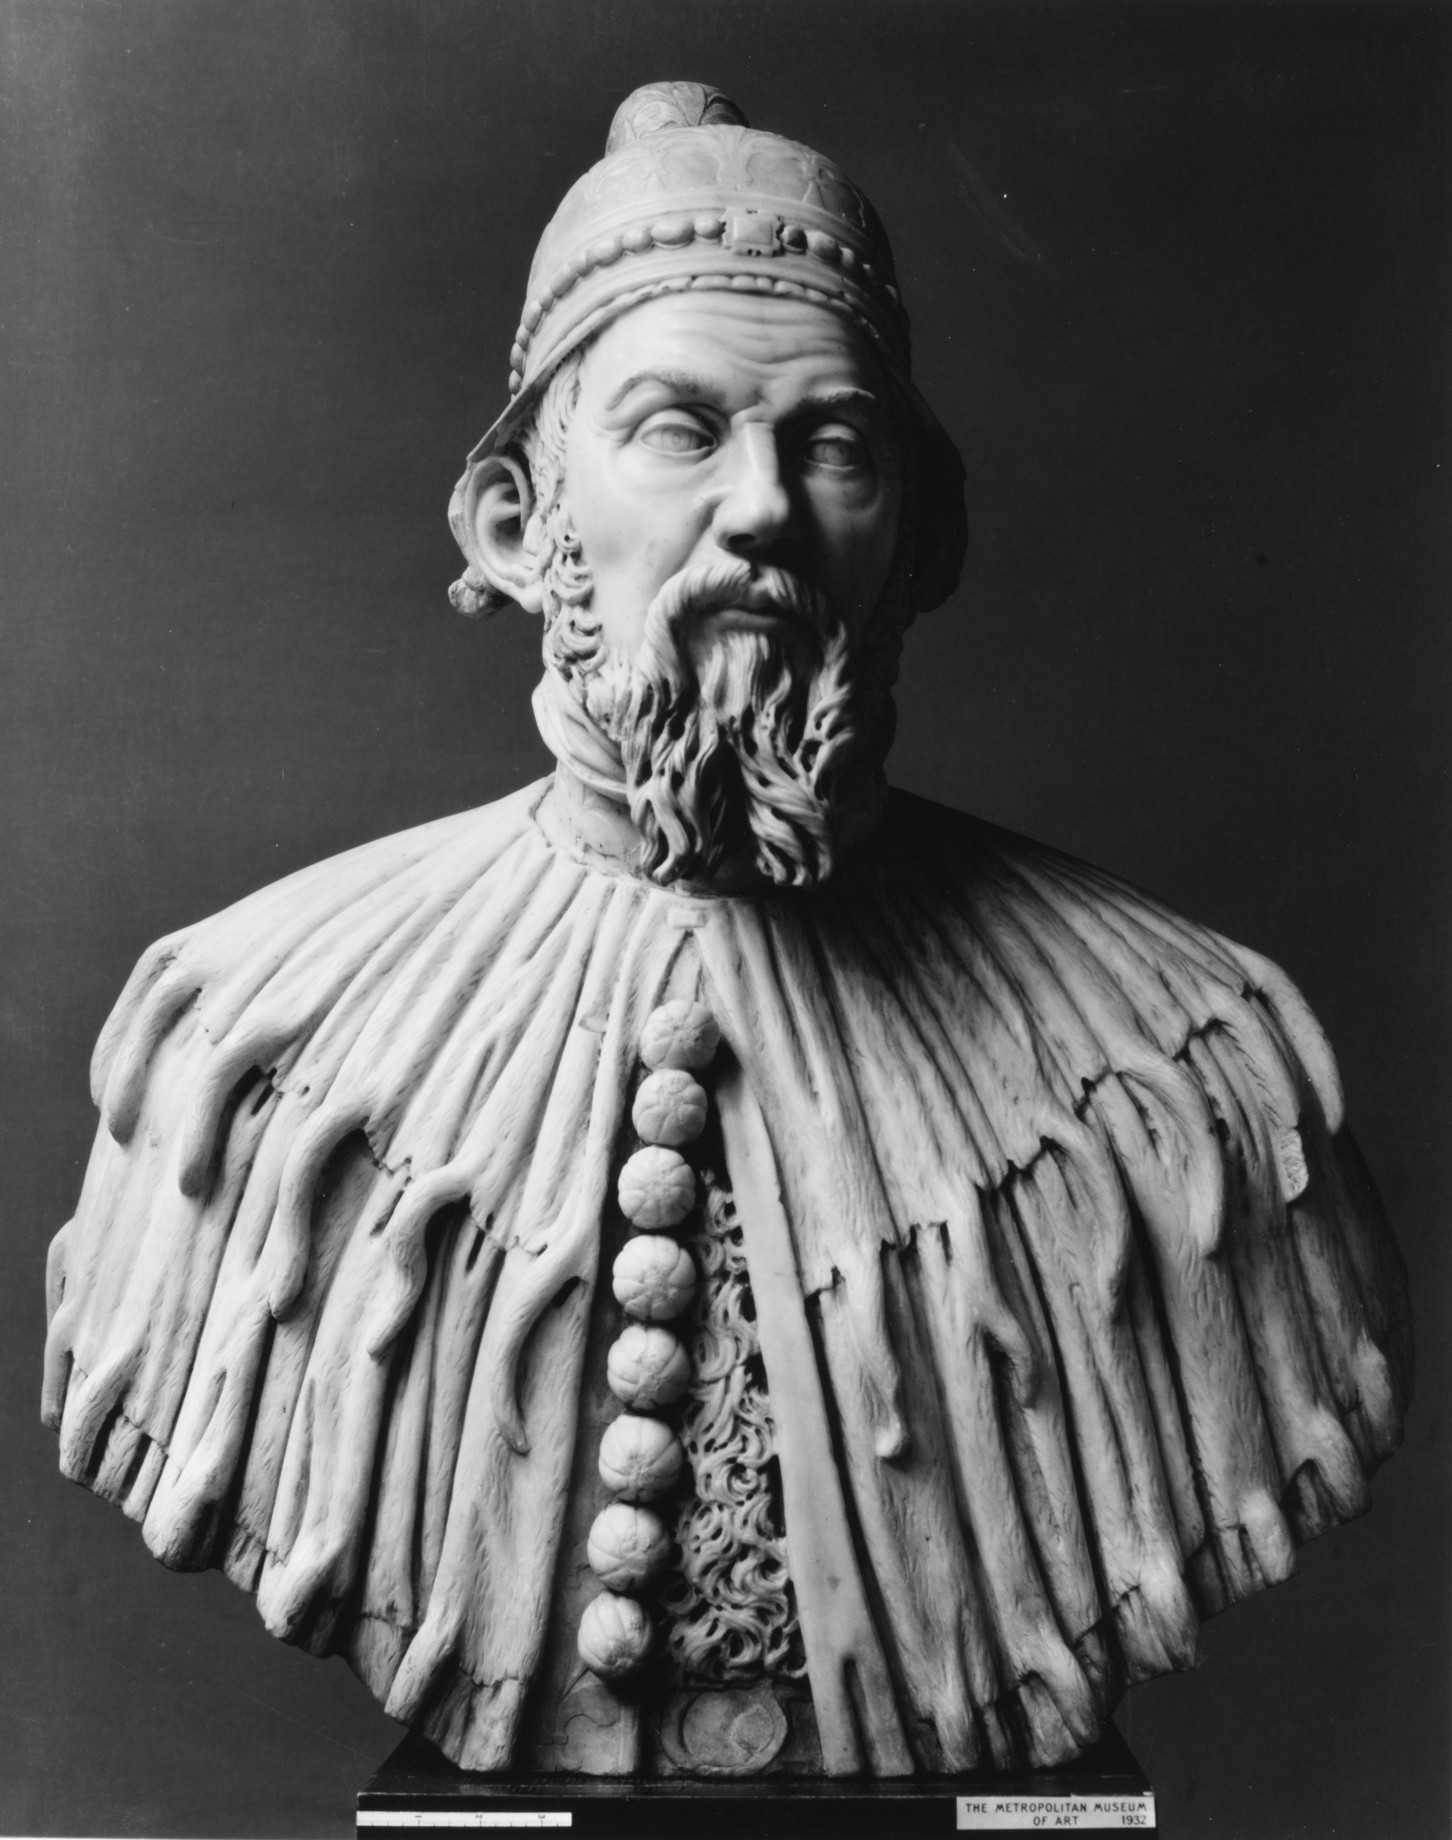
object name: bust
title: Portrait of Francesco Contarini, Doge 1623–1624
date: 1601-1700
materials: marble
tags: men,portraits